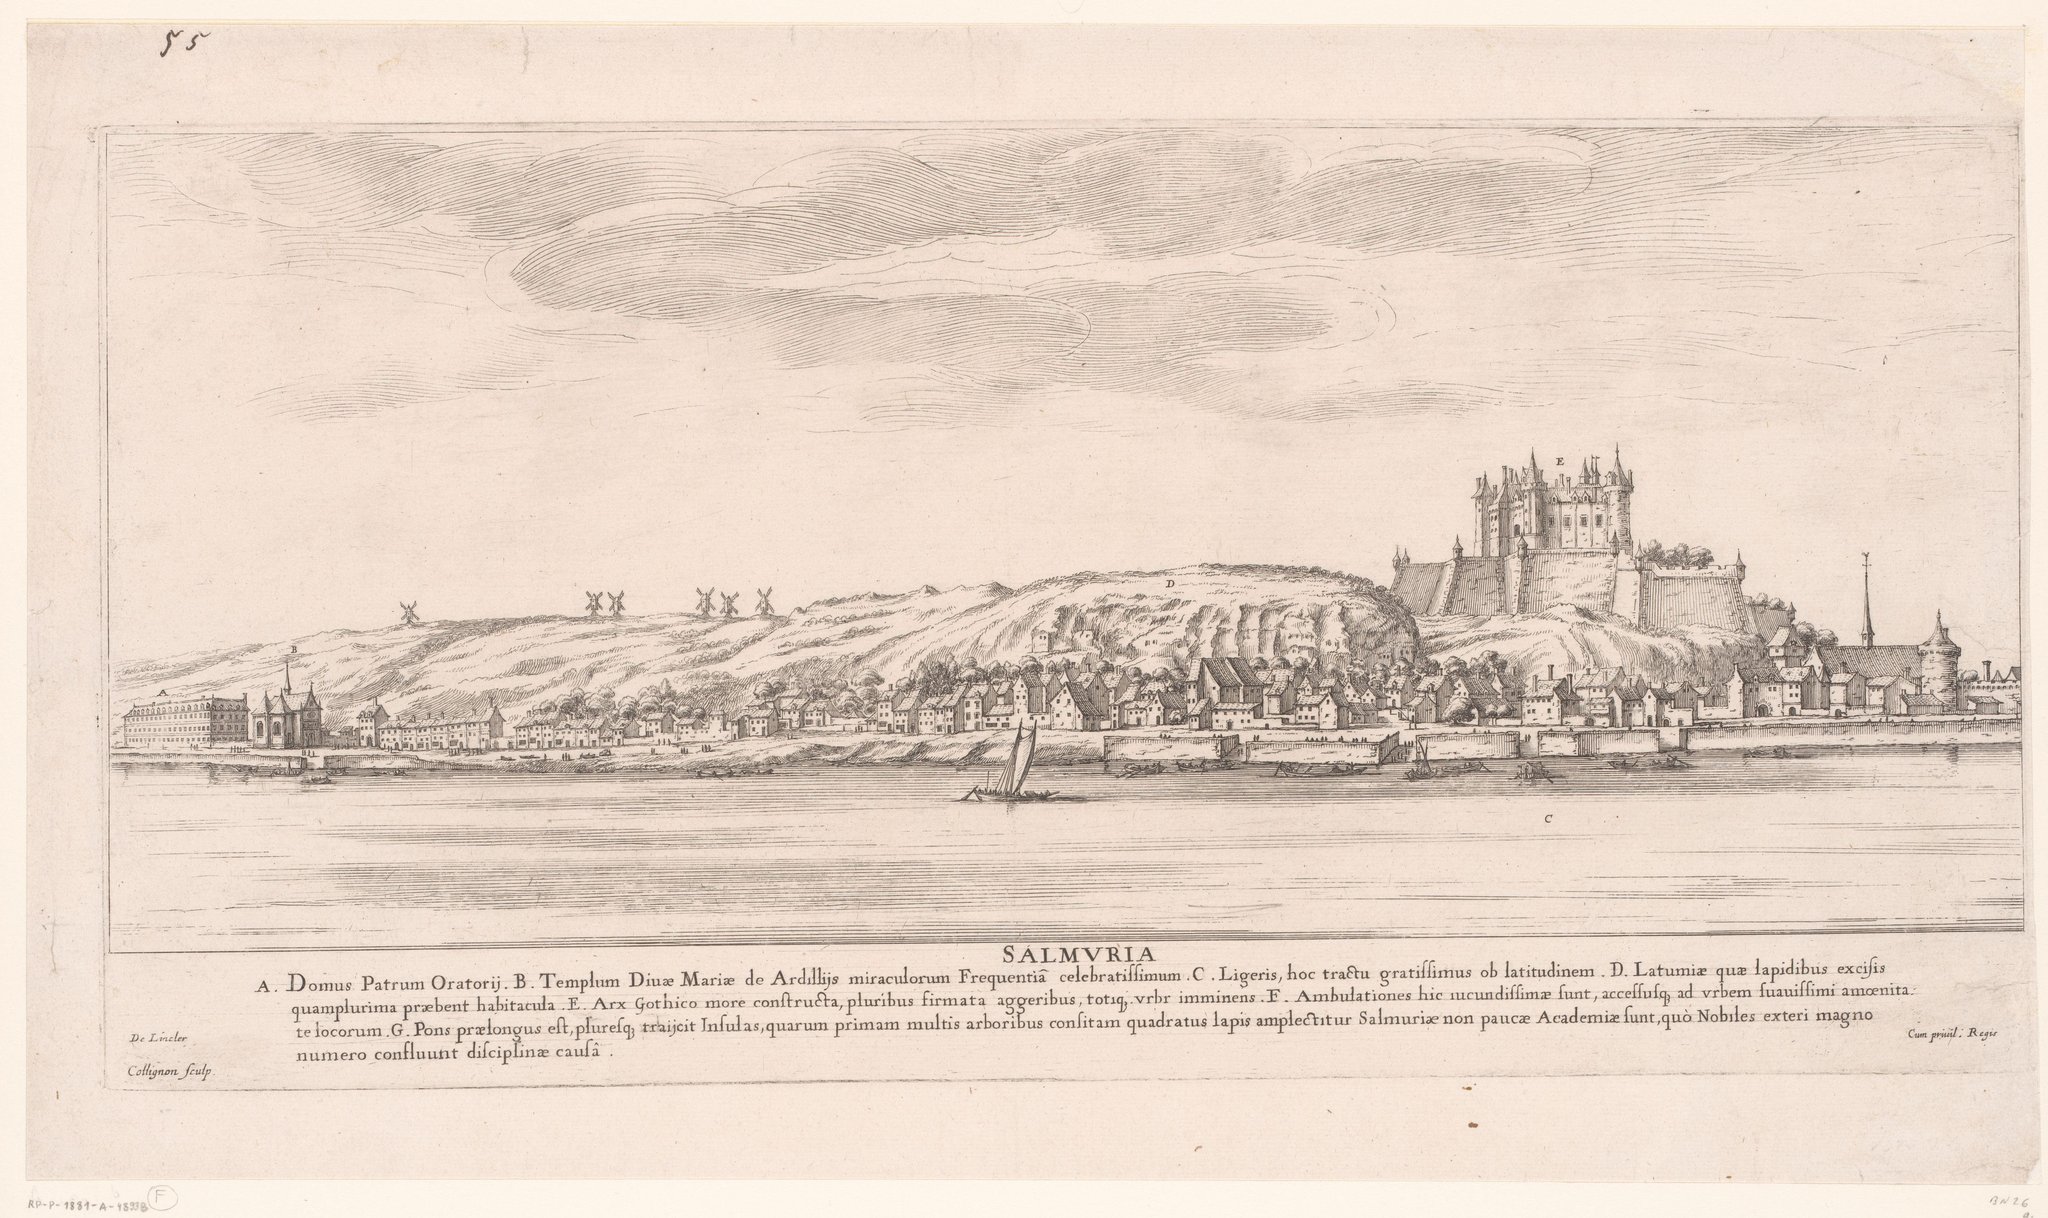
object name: print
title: Riviergezichten in Frankrijk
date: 1620-1687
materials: paper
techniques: etching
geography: paris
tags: city-view in general; 'veduta', river, windmill in landscape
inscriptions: watermark, collector's mark: Lugt 2228